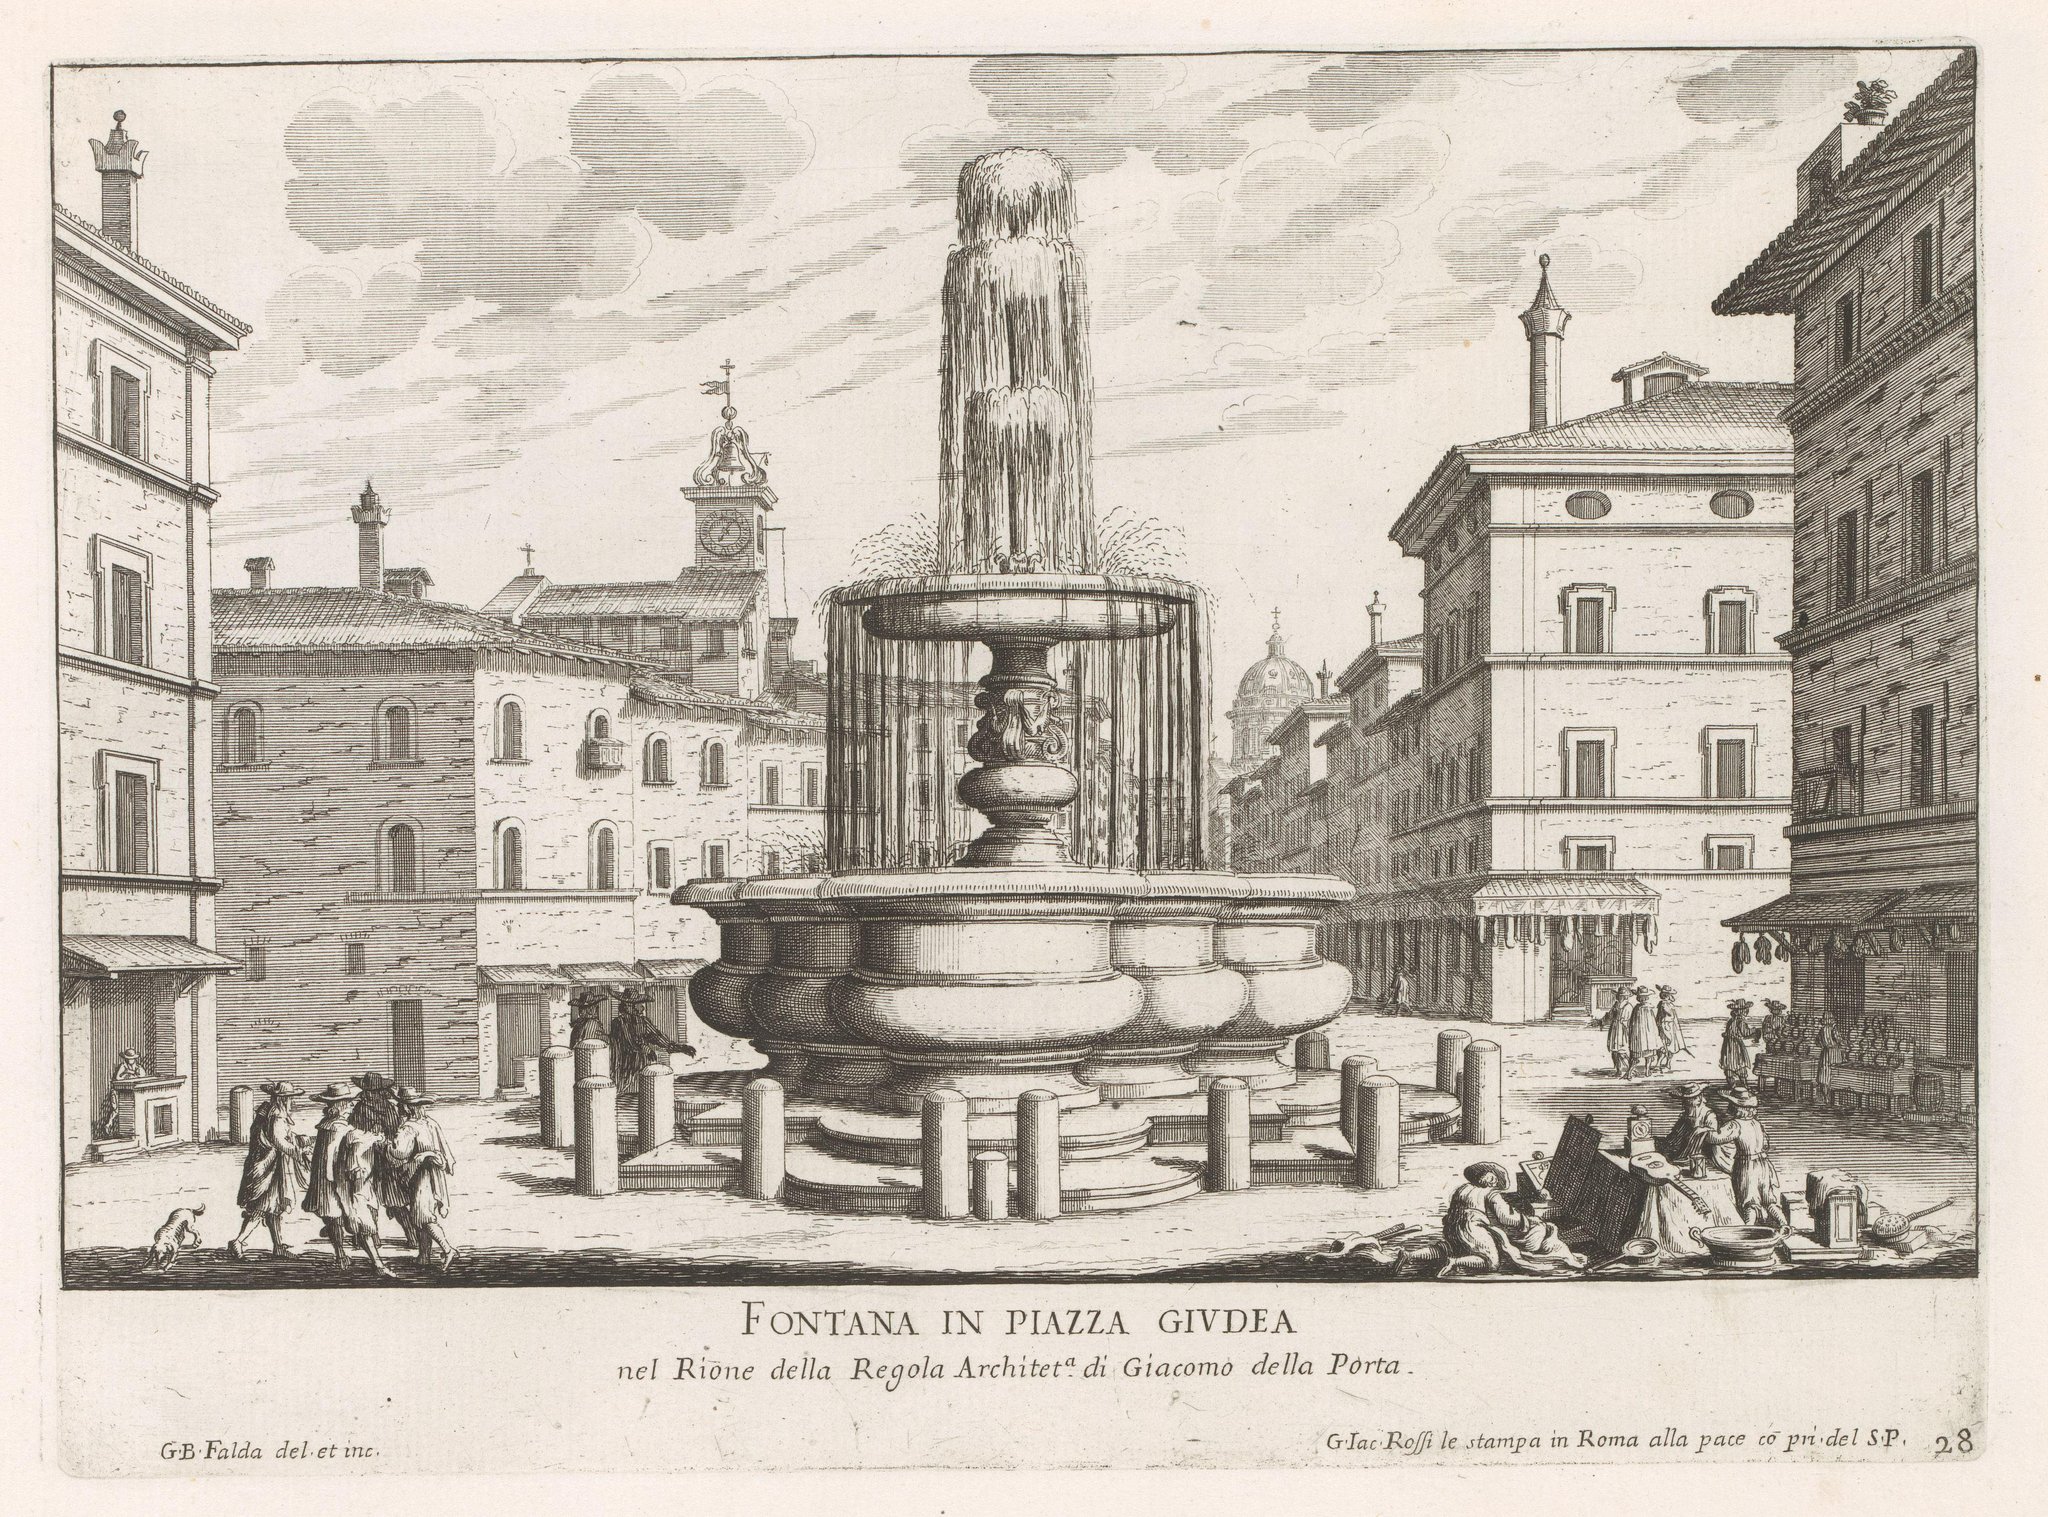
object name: print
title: Fontein op Piazza Giudia te Rome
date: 1653-1691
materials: paper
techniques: etching, intaglio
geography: rome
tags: ornamental fountain, rome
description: Fontein op Piazza Giudia, voorheen het centrale plein van het ghetto van Rome. De fontein wordt Fontana del Pianto genoemd en staat nu op Piazza delle Cinque Scole. Genummerd rechtsonder: 28. De prent maakt deel uit van een album.